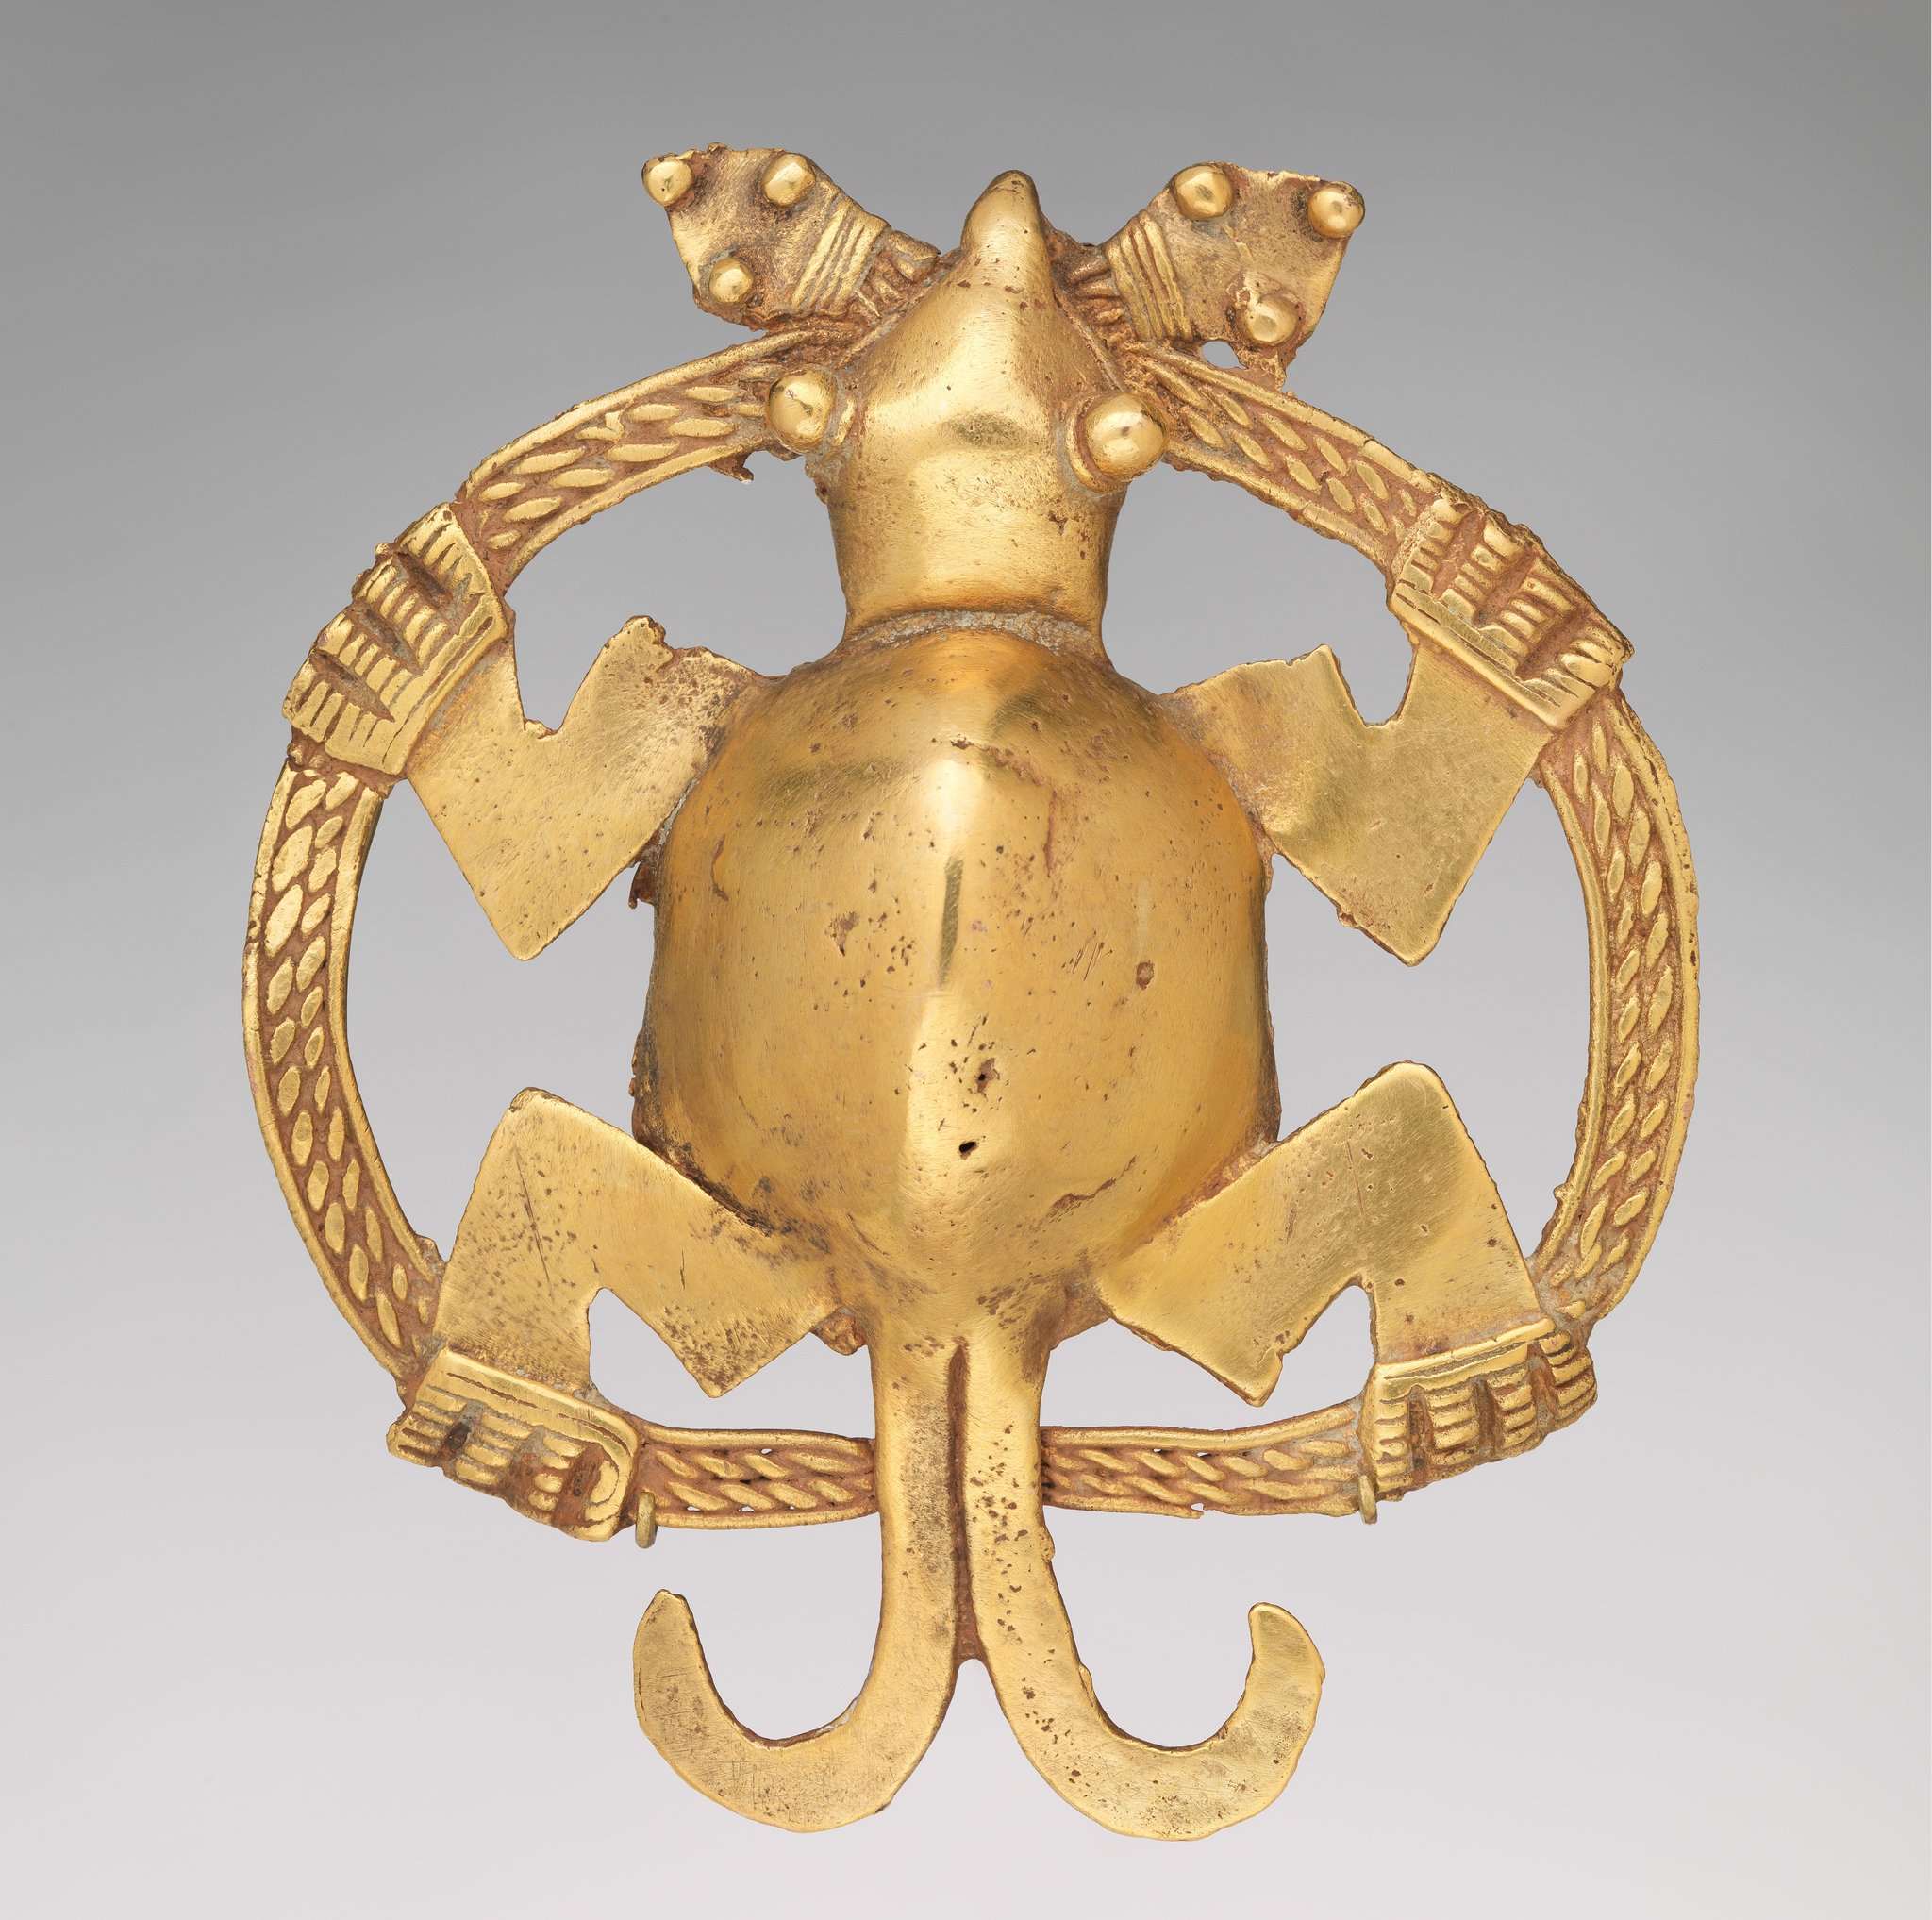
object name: pendant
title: Turtle Pendant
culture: veraguas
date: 1001-1600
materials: gold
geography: panama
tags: turtles